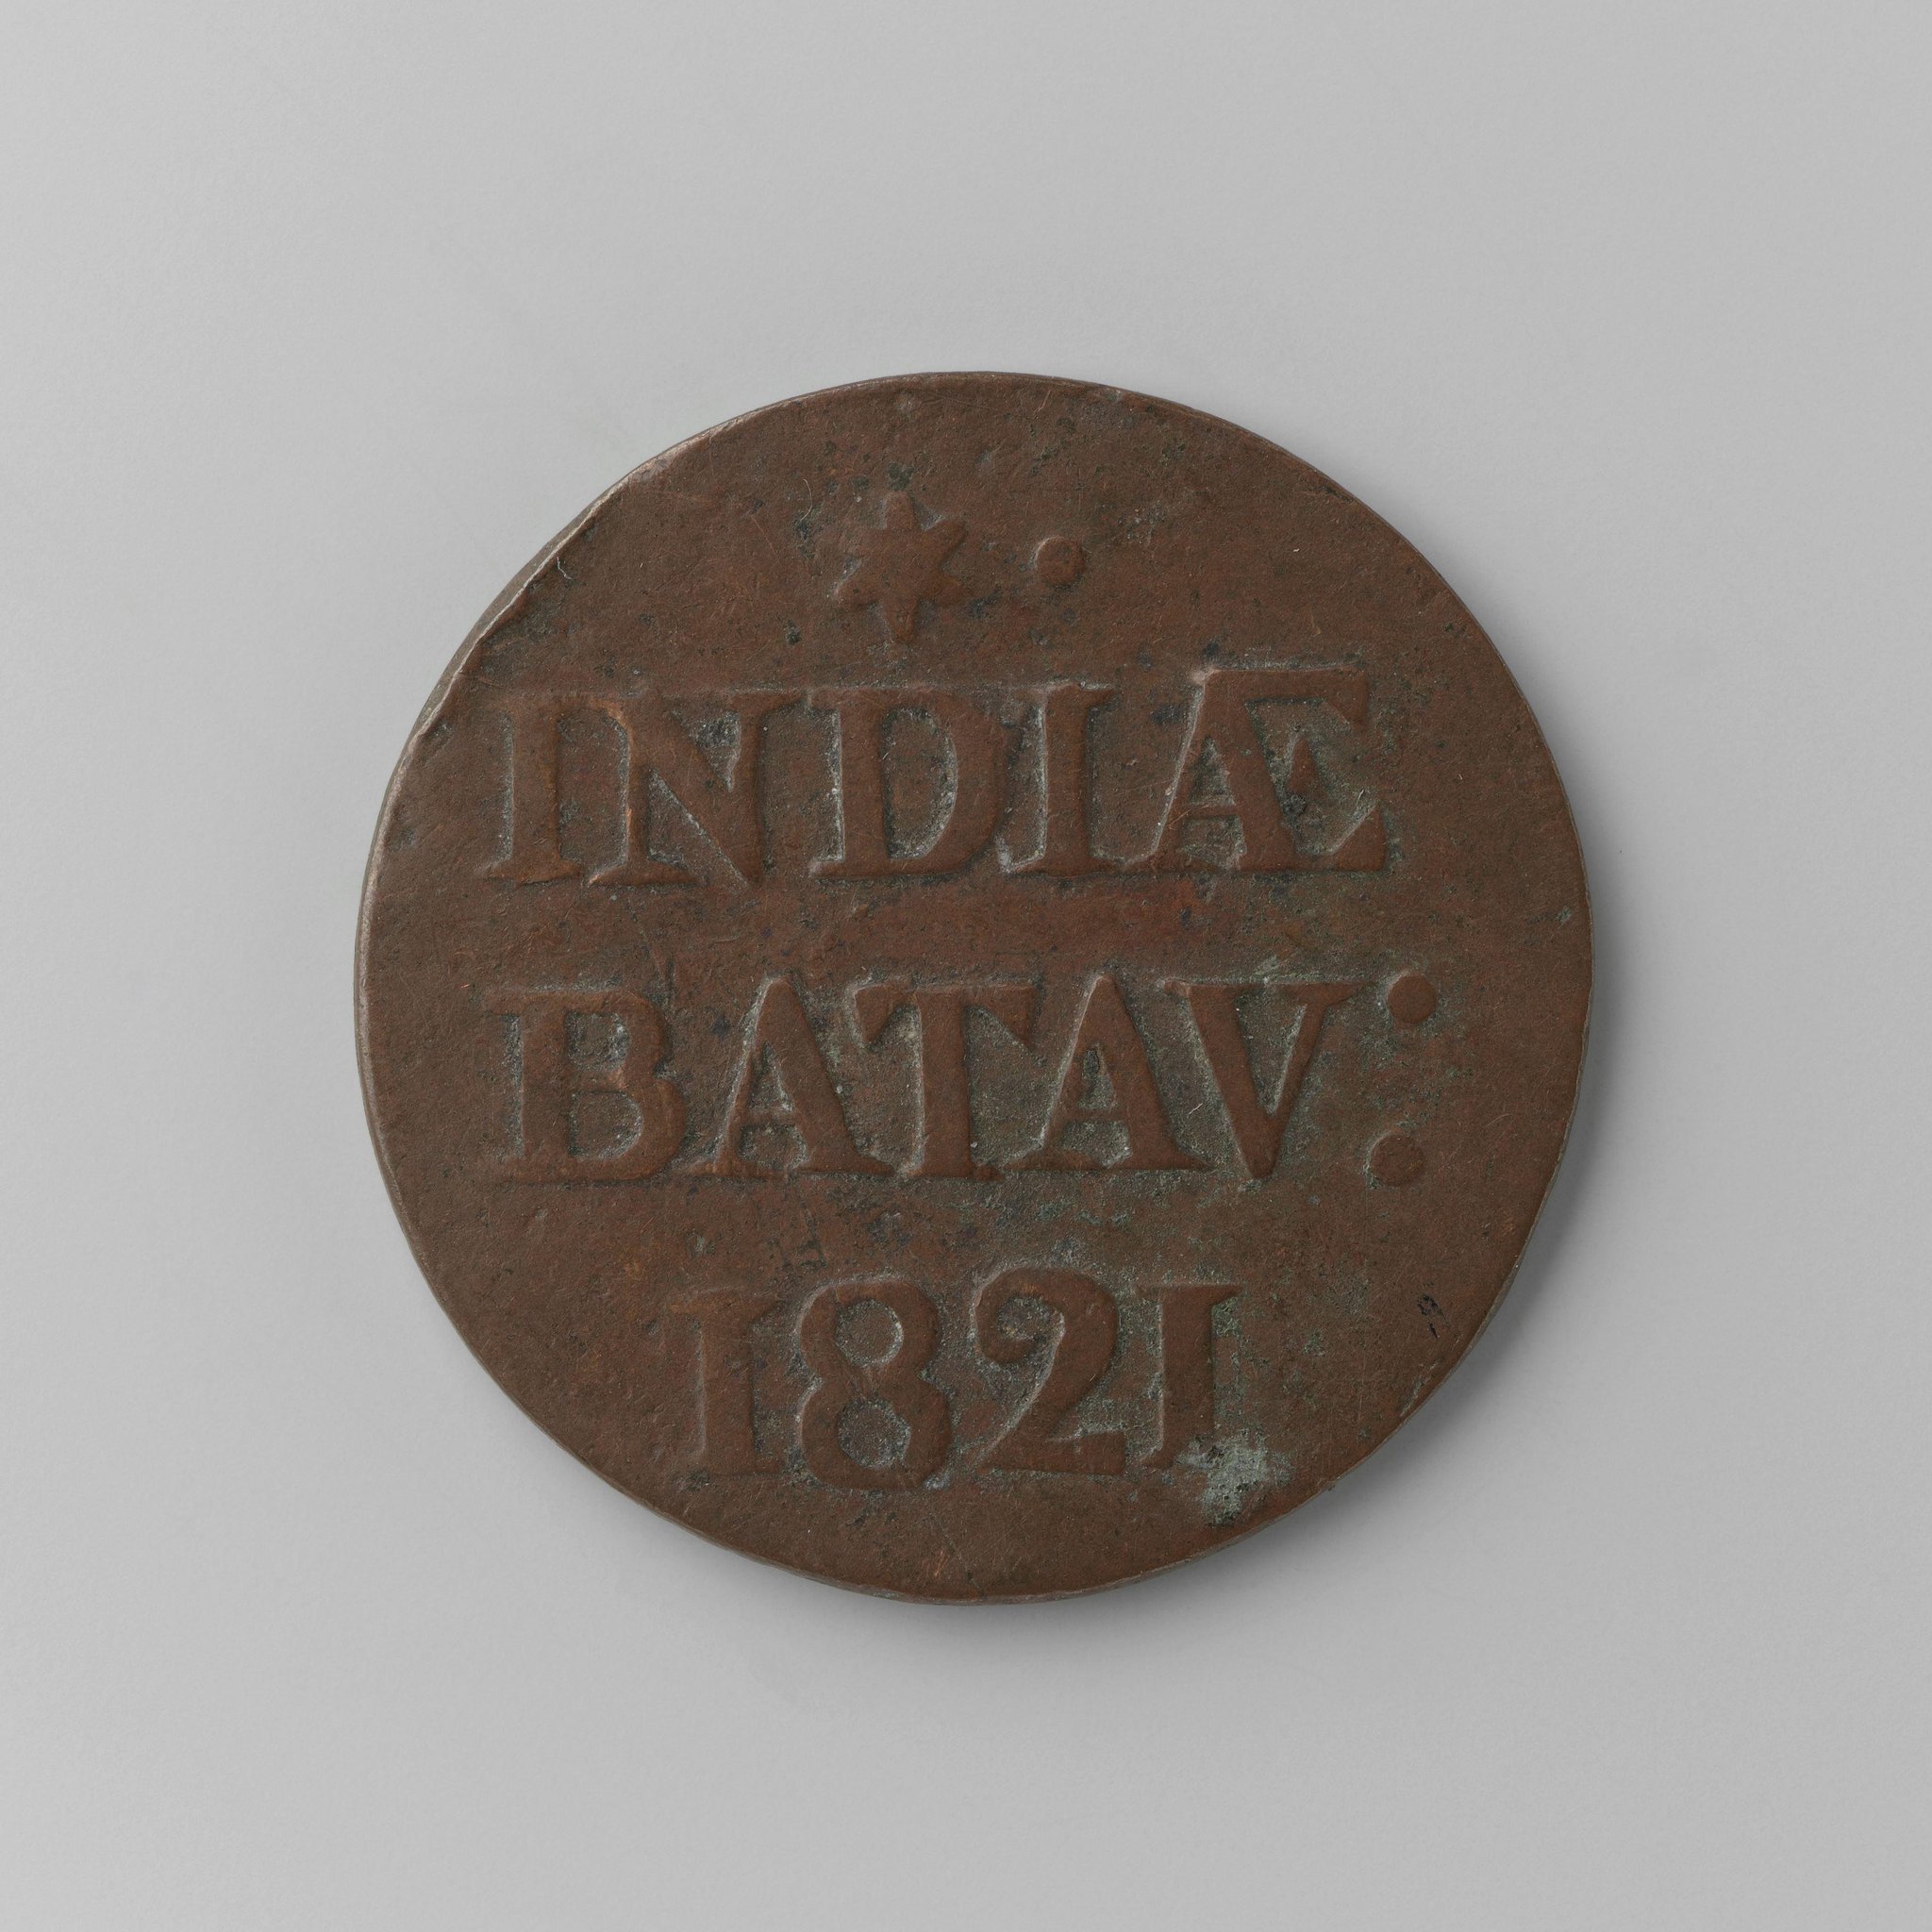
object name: coin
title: Nederlands Indië, duit,1821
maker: william i of the netherlands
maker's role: koning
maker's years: 1772-1843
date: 1821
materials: copper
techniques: striking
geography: surabaya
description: Koperen munt. Voorzijde: tussen waarde-aanduiding 5 1/16 G. gekroond generaliteitswapenschild. Keerzijde: tweeregelig opschrift, waarboven muntteken en waaronder jaartal. Gladde rand.